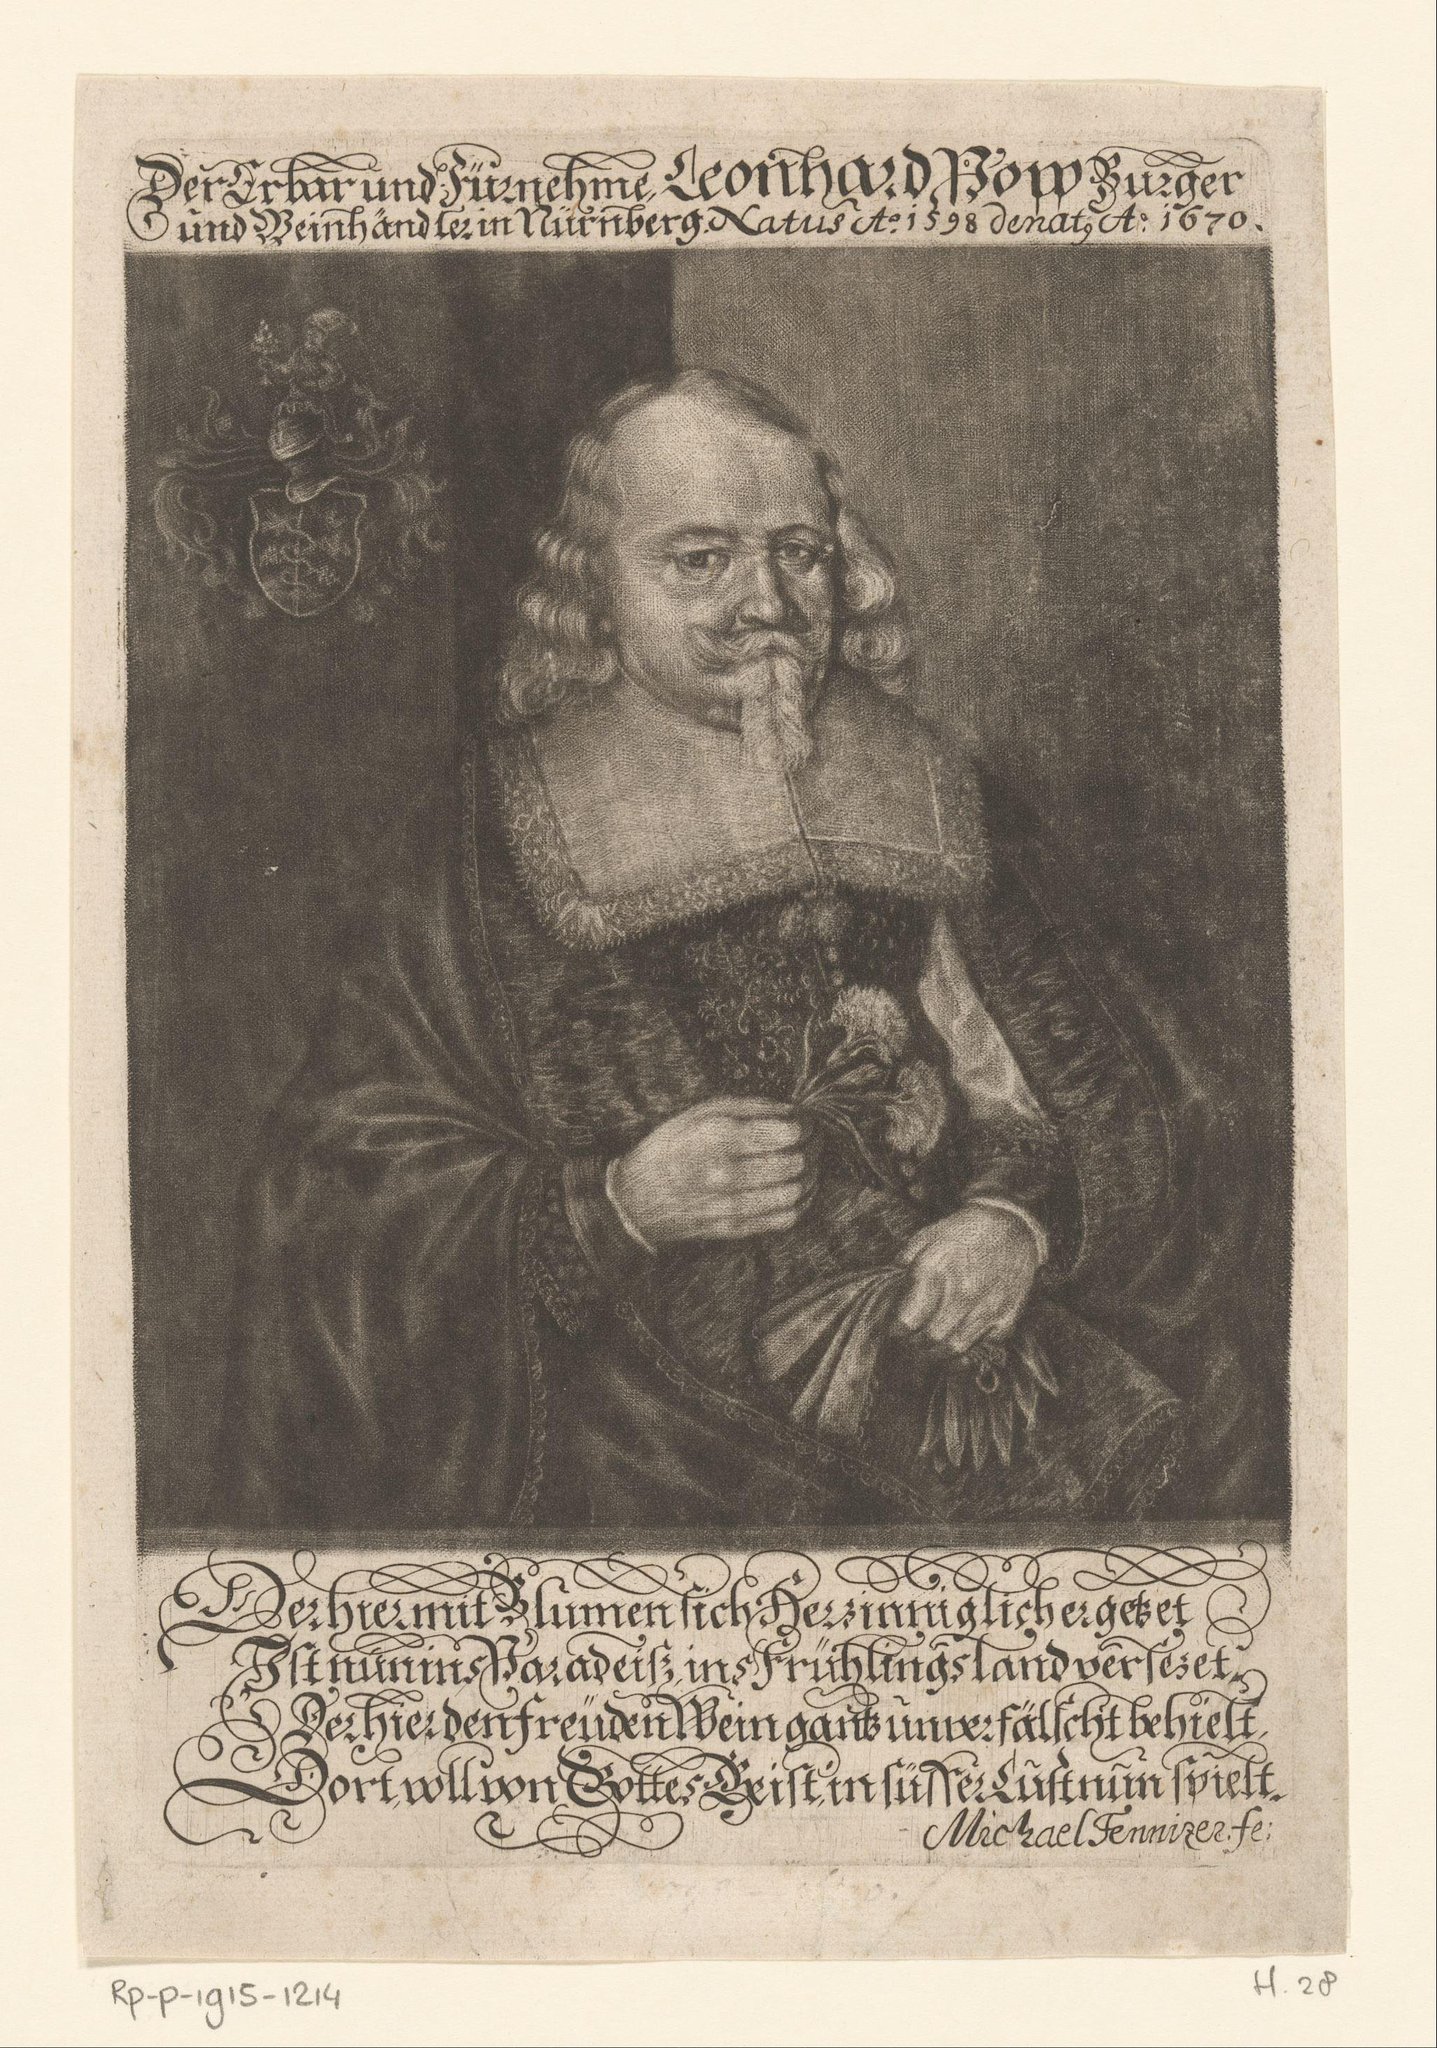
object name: print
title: Portret van Leonhard Popp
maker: michael fennitzer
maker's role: print maker, printer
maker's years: 1641-1702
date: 1670-1702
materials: paper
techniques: mezzotint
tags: cut flowers; nosegay, bunch of flowers, gloves, mittens, etc., historical persons, armorial bearing, heraldry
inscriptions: collector's mark: Lugt 2228